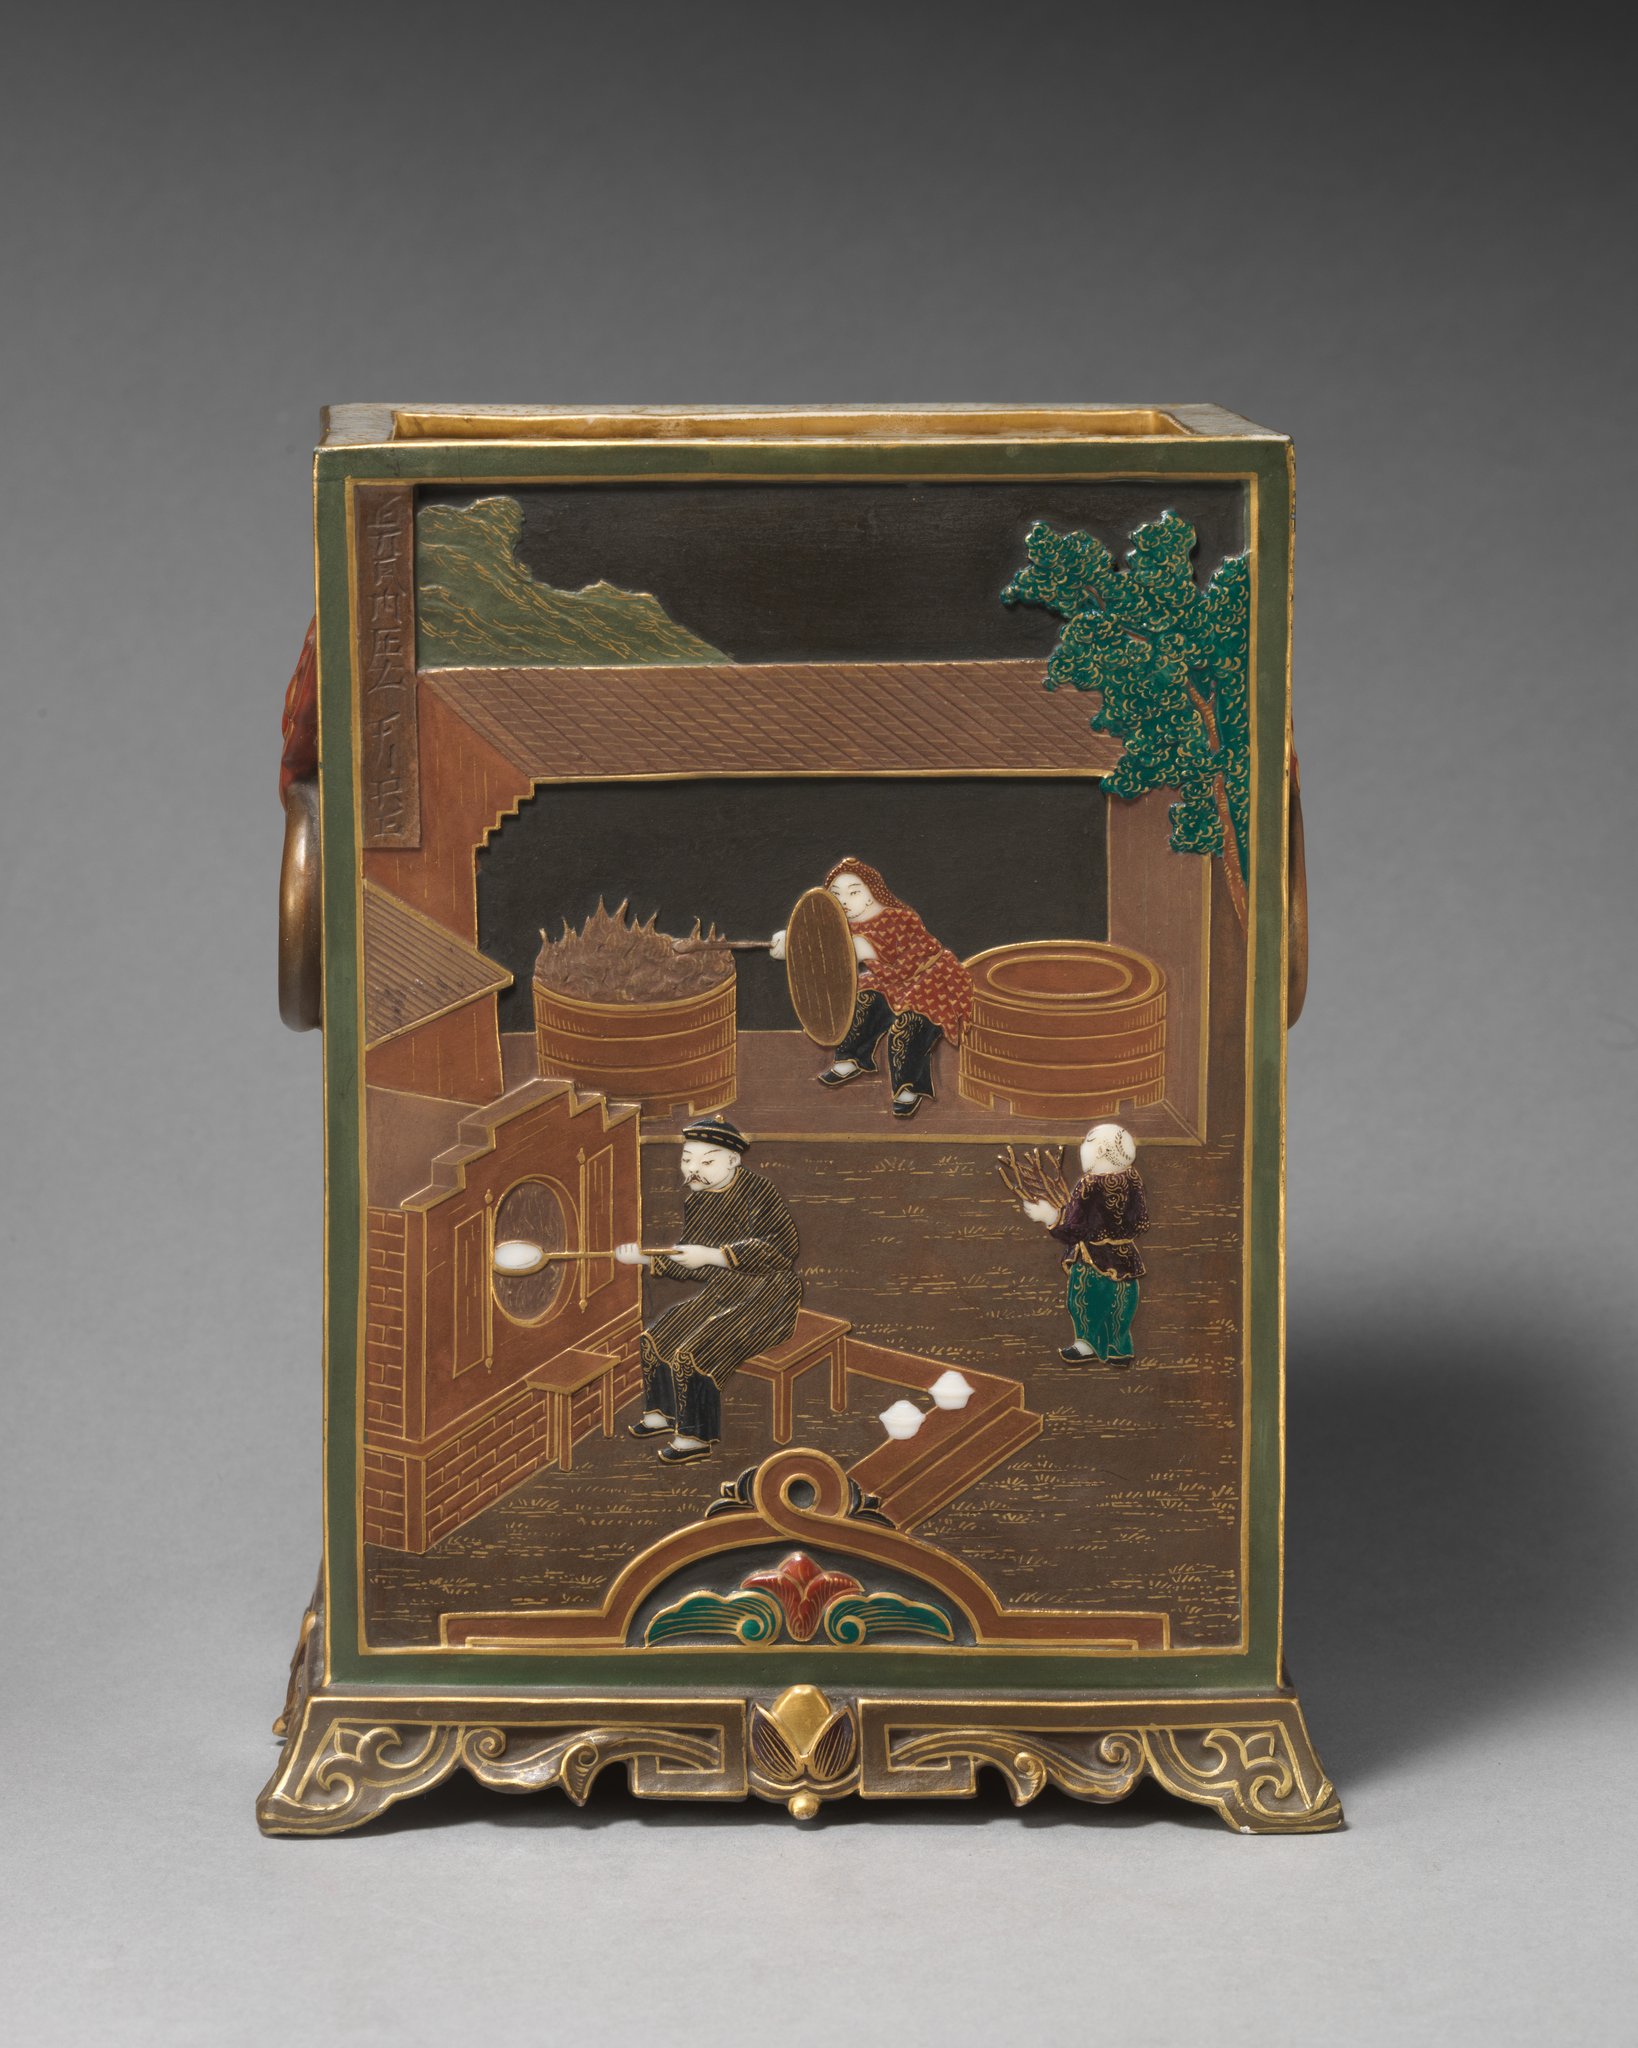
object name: vase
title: Rectangular vase with porcelain-making scenes ("the oven for burning clay" and "the painting of the wares")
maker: worcester factory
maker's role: manufactory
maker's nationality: british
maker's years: 1751-2008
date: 1872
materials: bone china, enamel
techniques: gilding